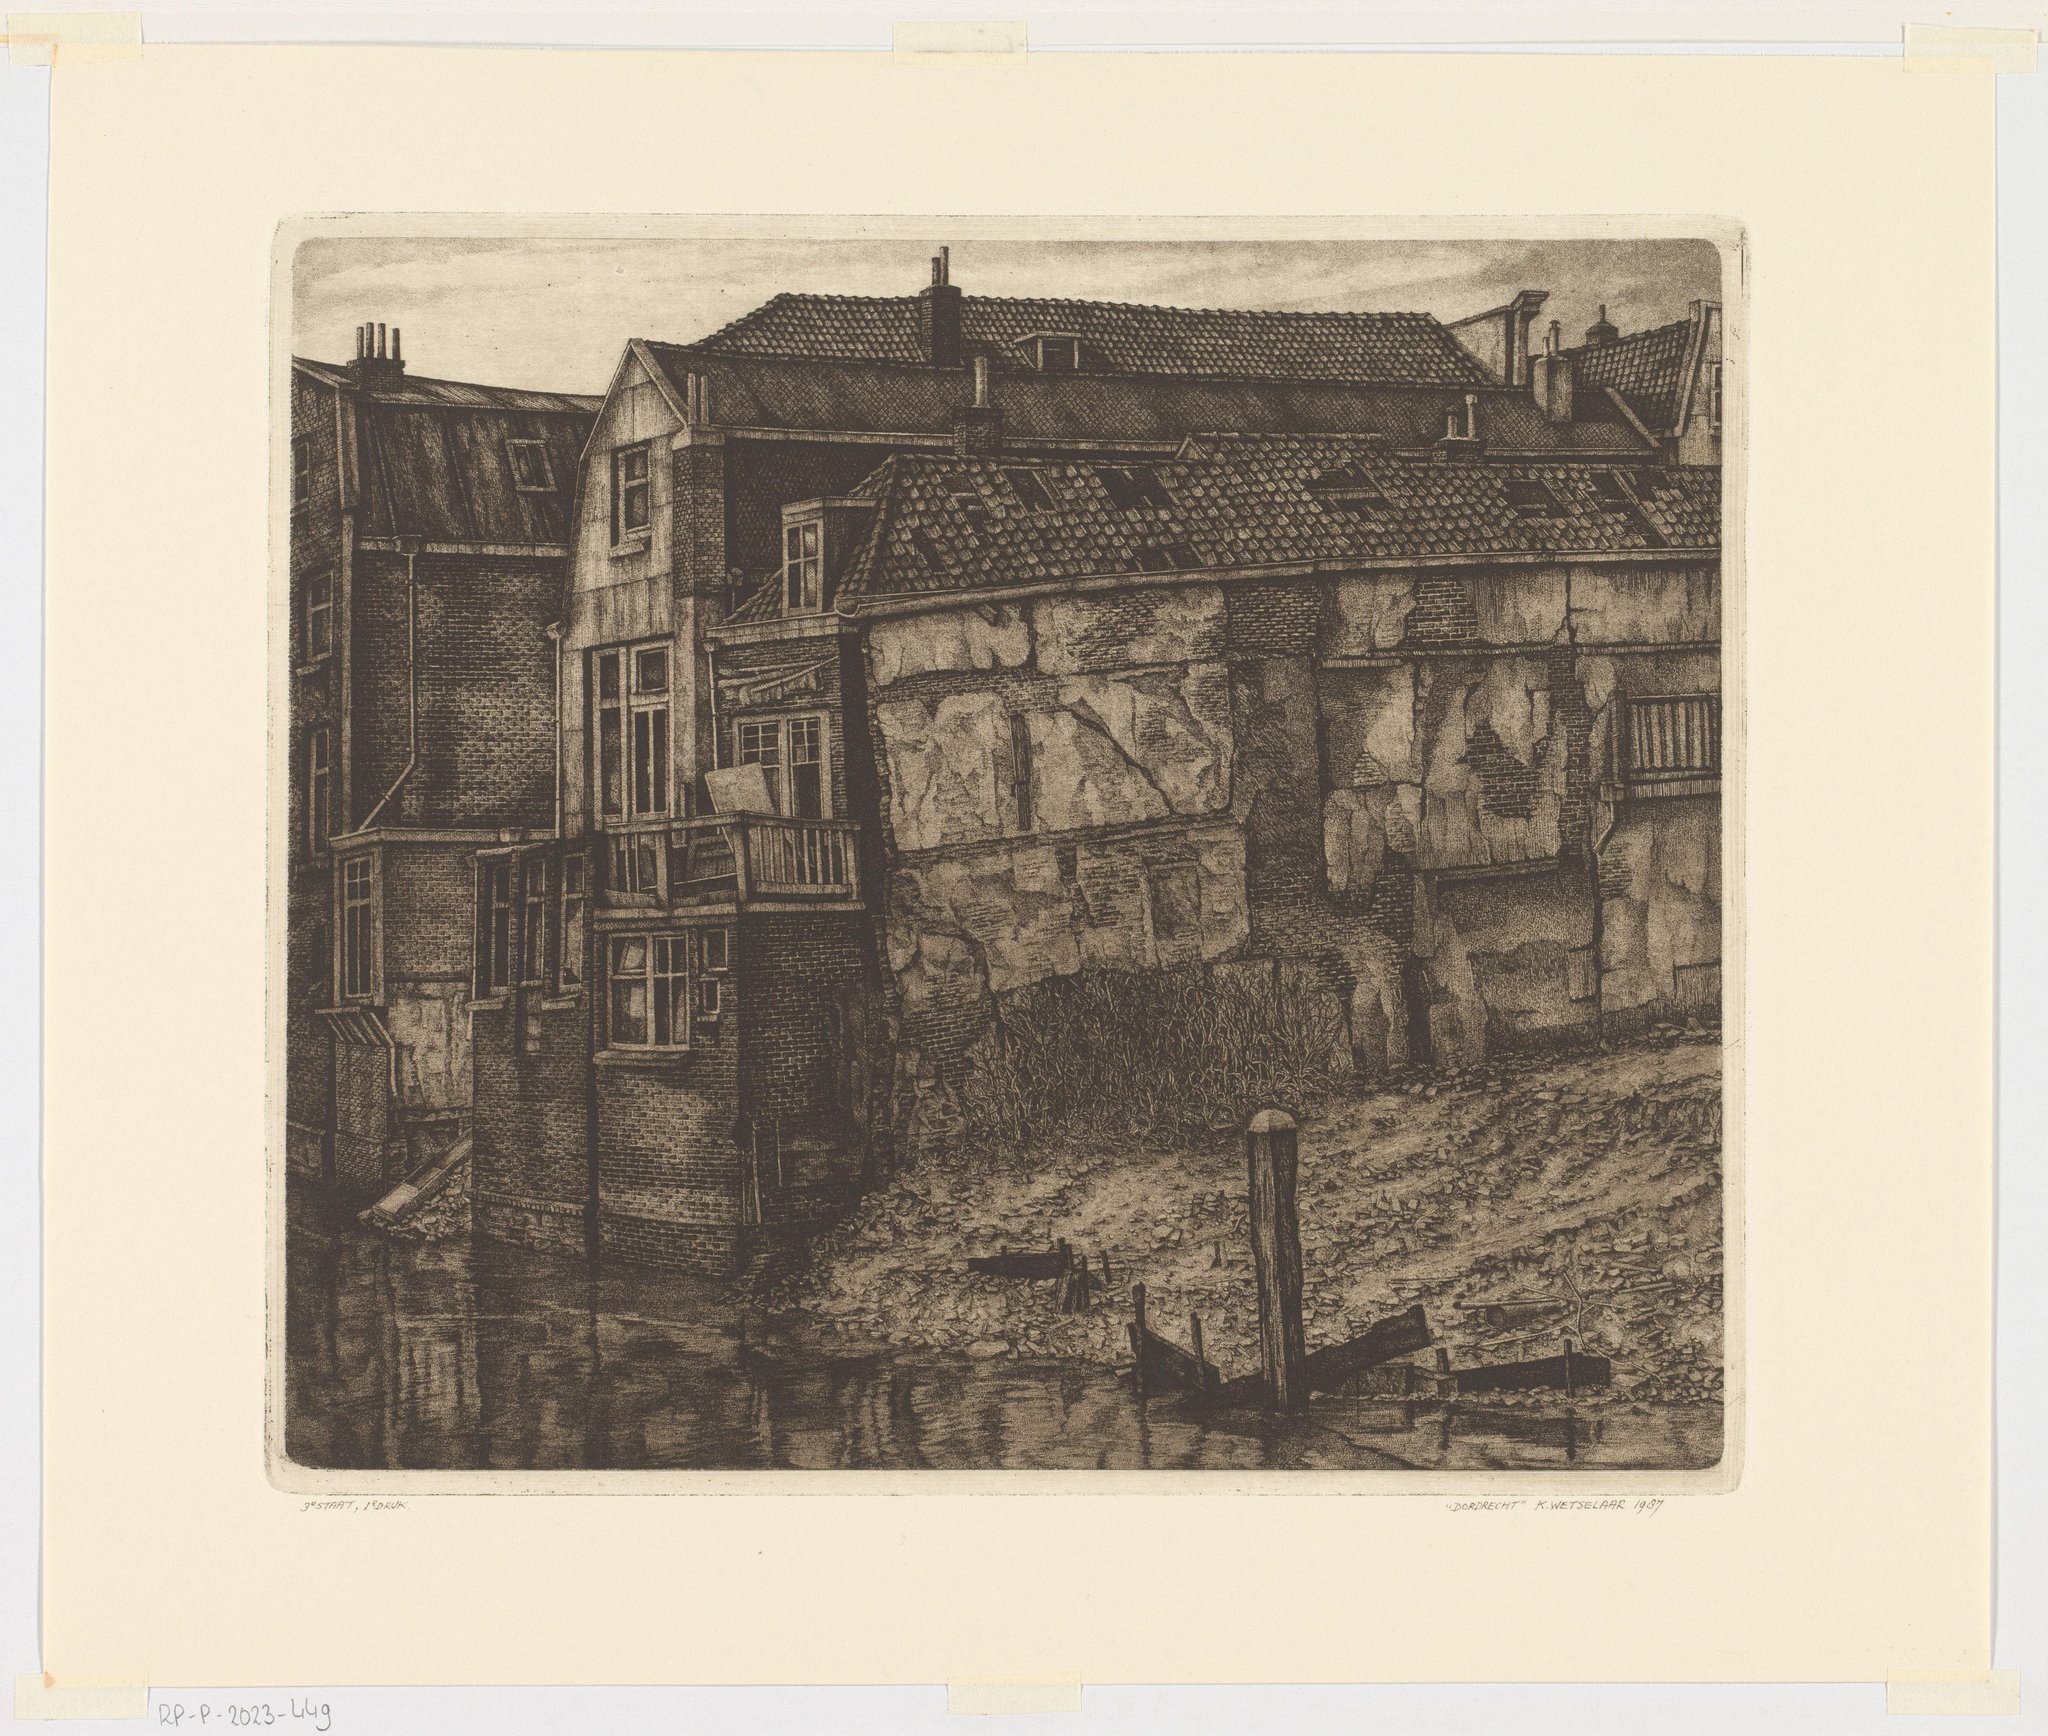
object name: print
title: Dordrecht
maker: karel wetselaar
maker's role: print maker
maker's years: 1935-2017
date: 1987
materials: paper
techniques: etching, retroussage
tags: façade (of house or building), dordrecht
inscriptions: signature and date: ‘K. Wetselaar 1987’, inscription: ‘3e staat, 1e druk’